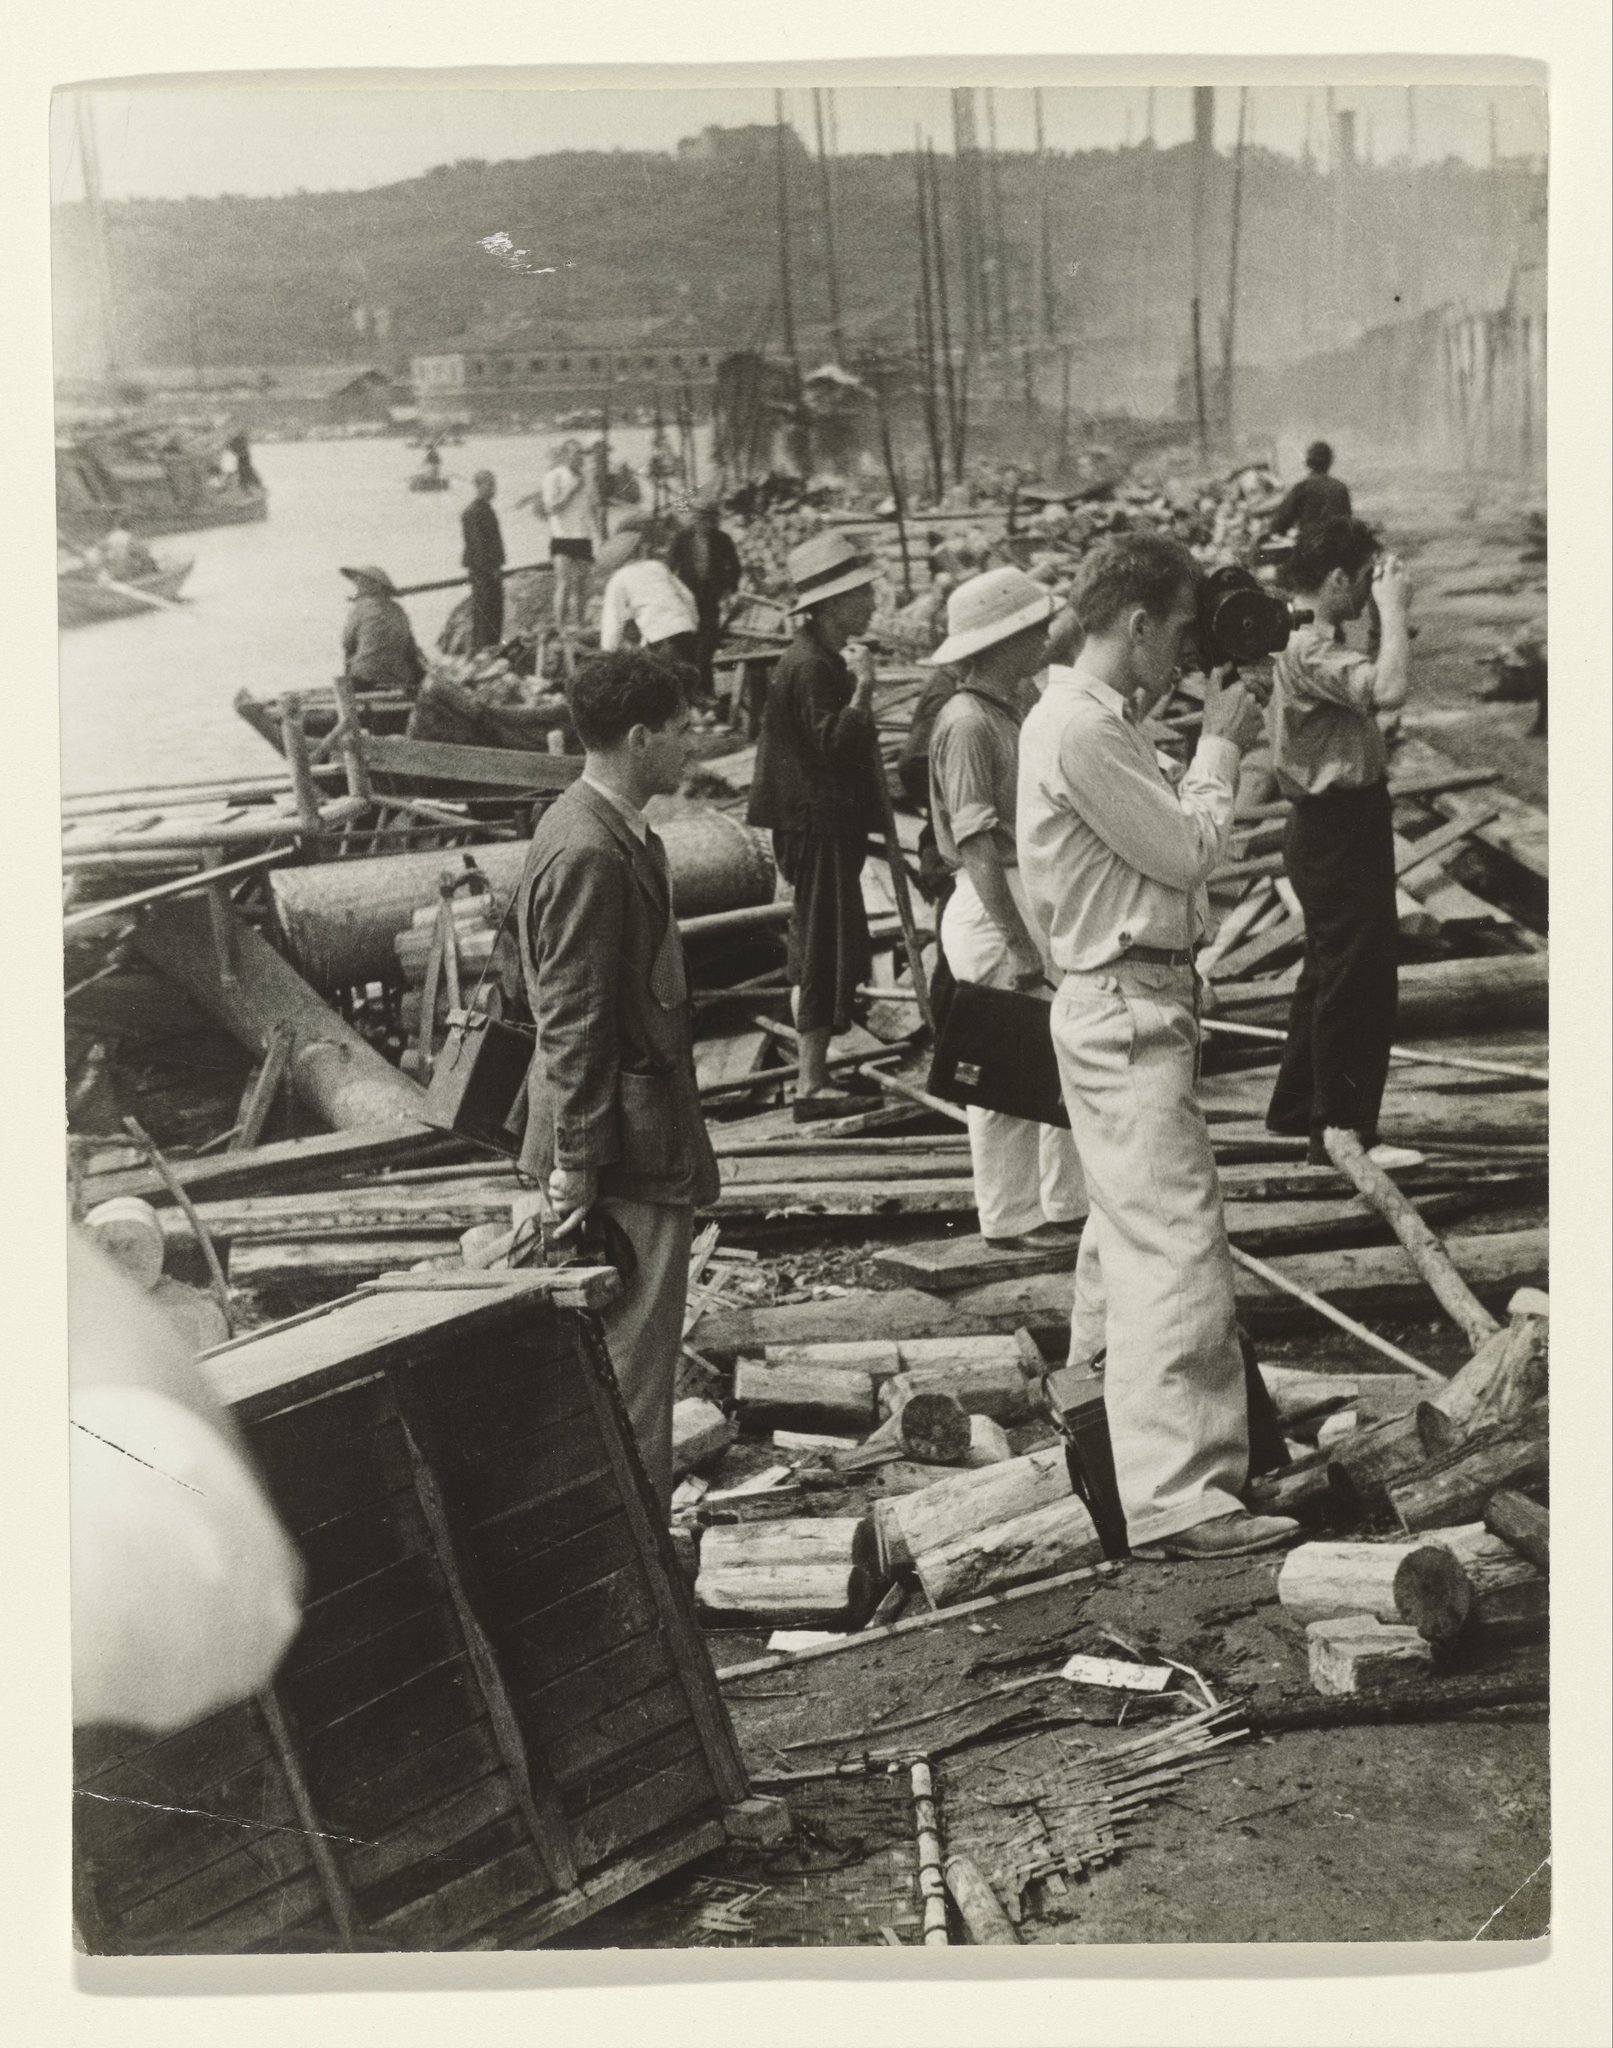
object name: photograph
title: Joris Ivens, John Fernhout and Robert Capa at Work in the Bombed City of Hankow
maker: Anonymous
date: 1907-1938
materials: paper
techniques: gelatin silver print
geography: hankou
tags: robert capa, john fernhout, nijmegen, paris, joris ivens, photographer at work - cc - out of doors, filming, cinematographer at work - cc - out of doors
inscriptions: stamp: ‘E 222’, inscription: ‘foto door chinese camera assistent’